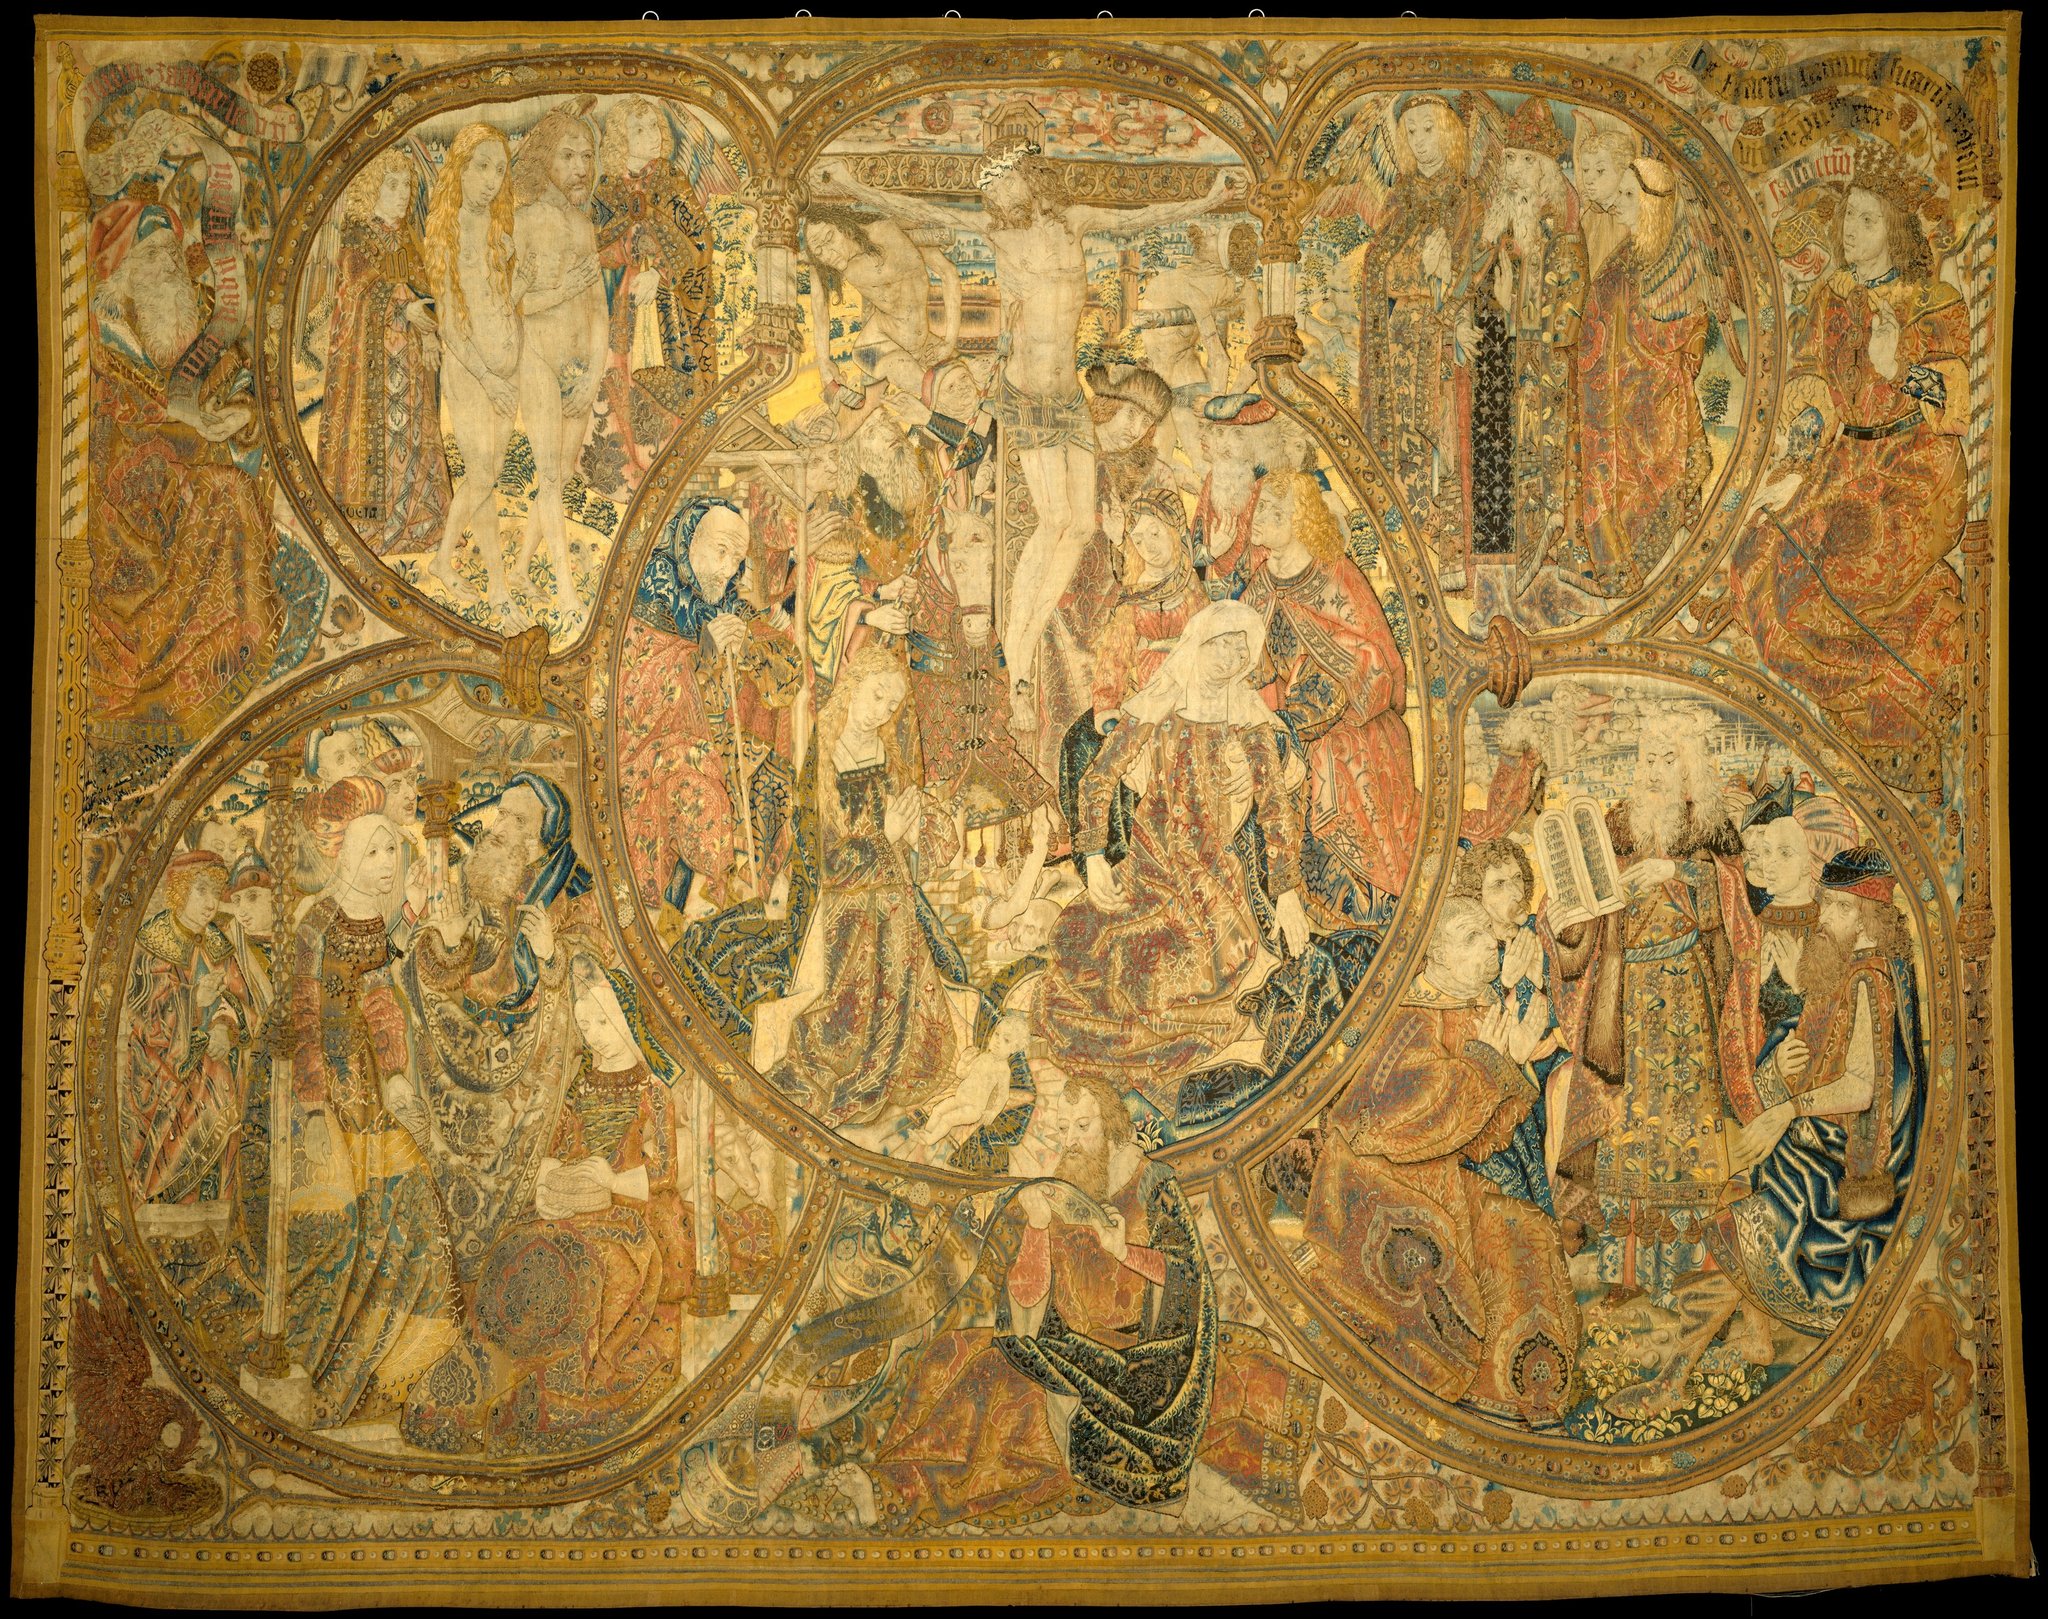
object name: tapestry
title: The Fall and Redemption of Man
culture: south netherlandish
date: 1480-1490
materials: gilt, silk, silver, wool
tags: christ,adam,eve,crucifixion,nativity